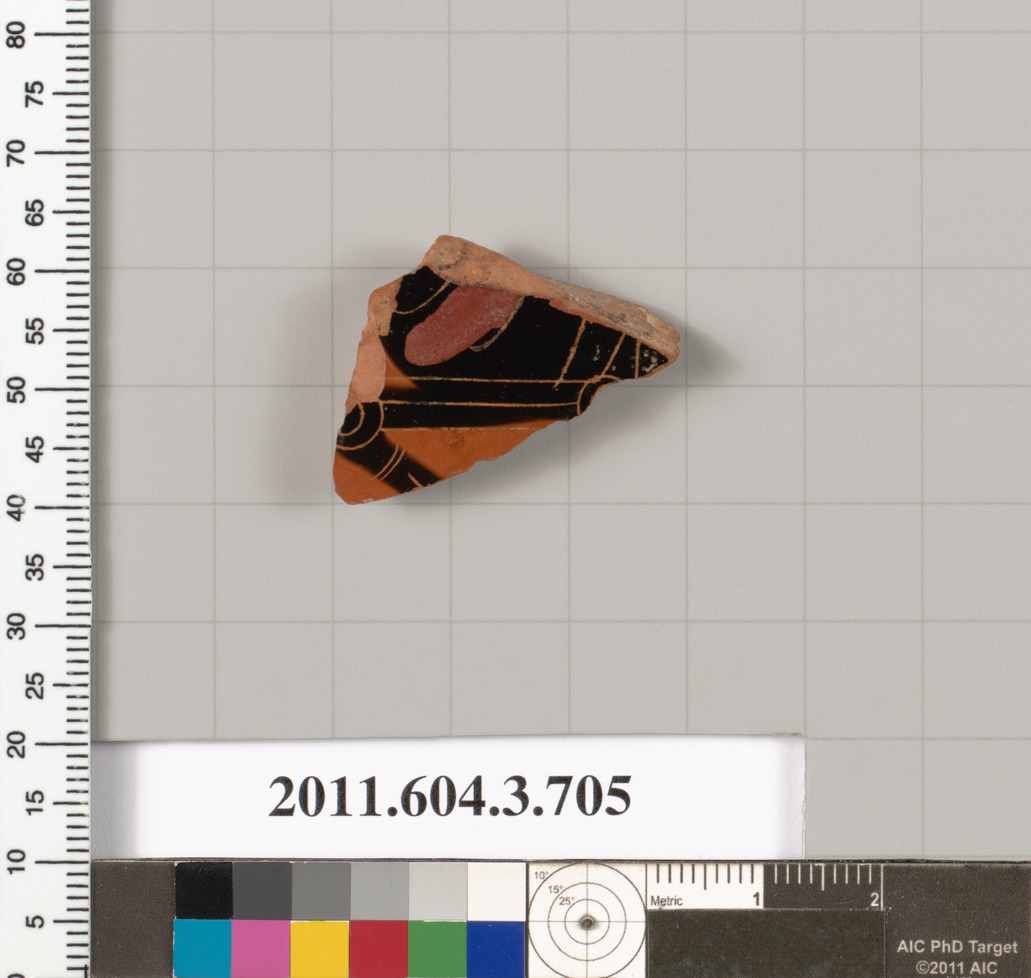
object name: hydria fragment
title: Terracotta fragment of a hydria (water jar)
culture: greek, attic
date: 525-501 BCE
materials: terracotta